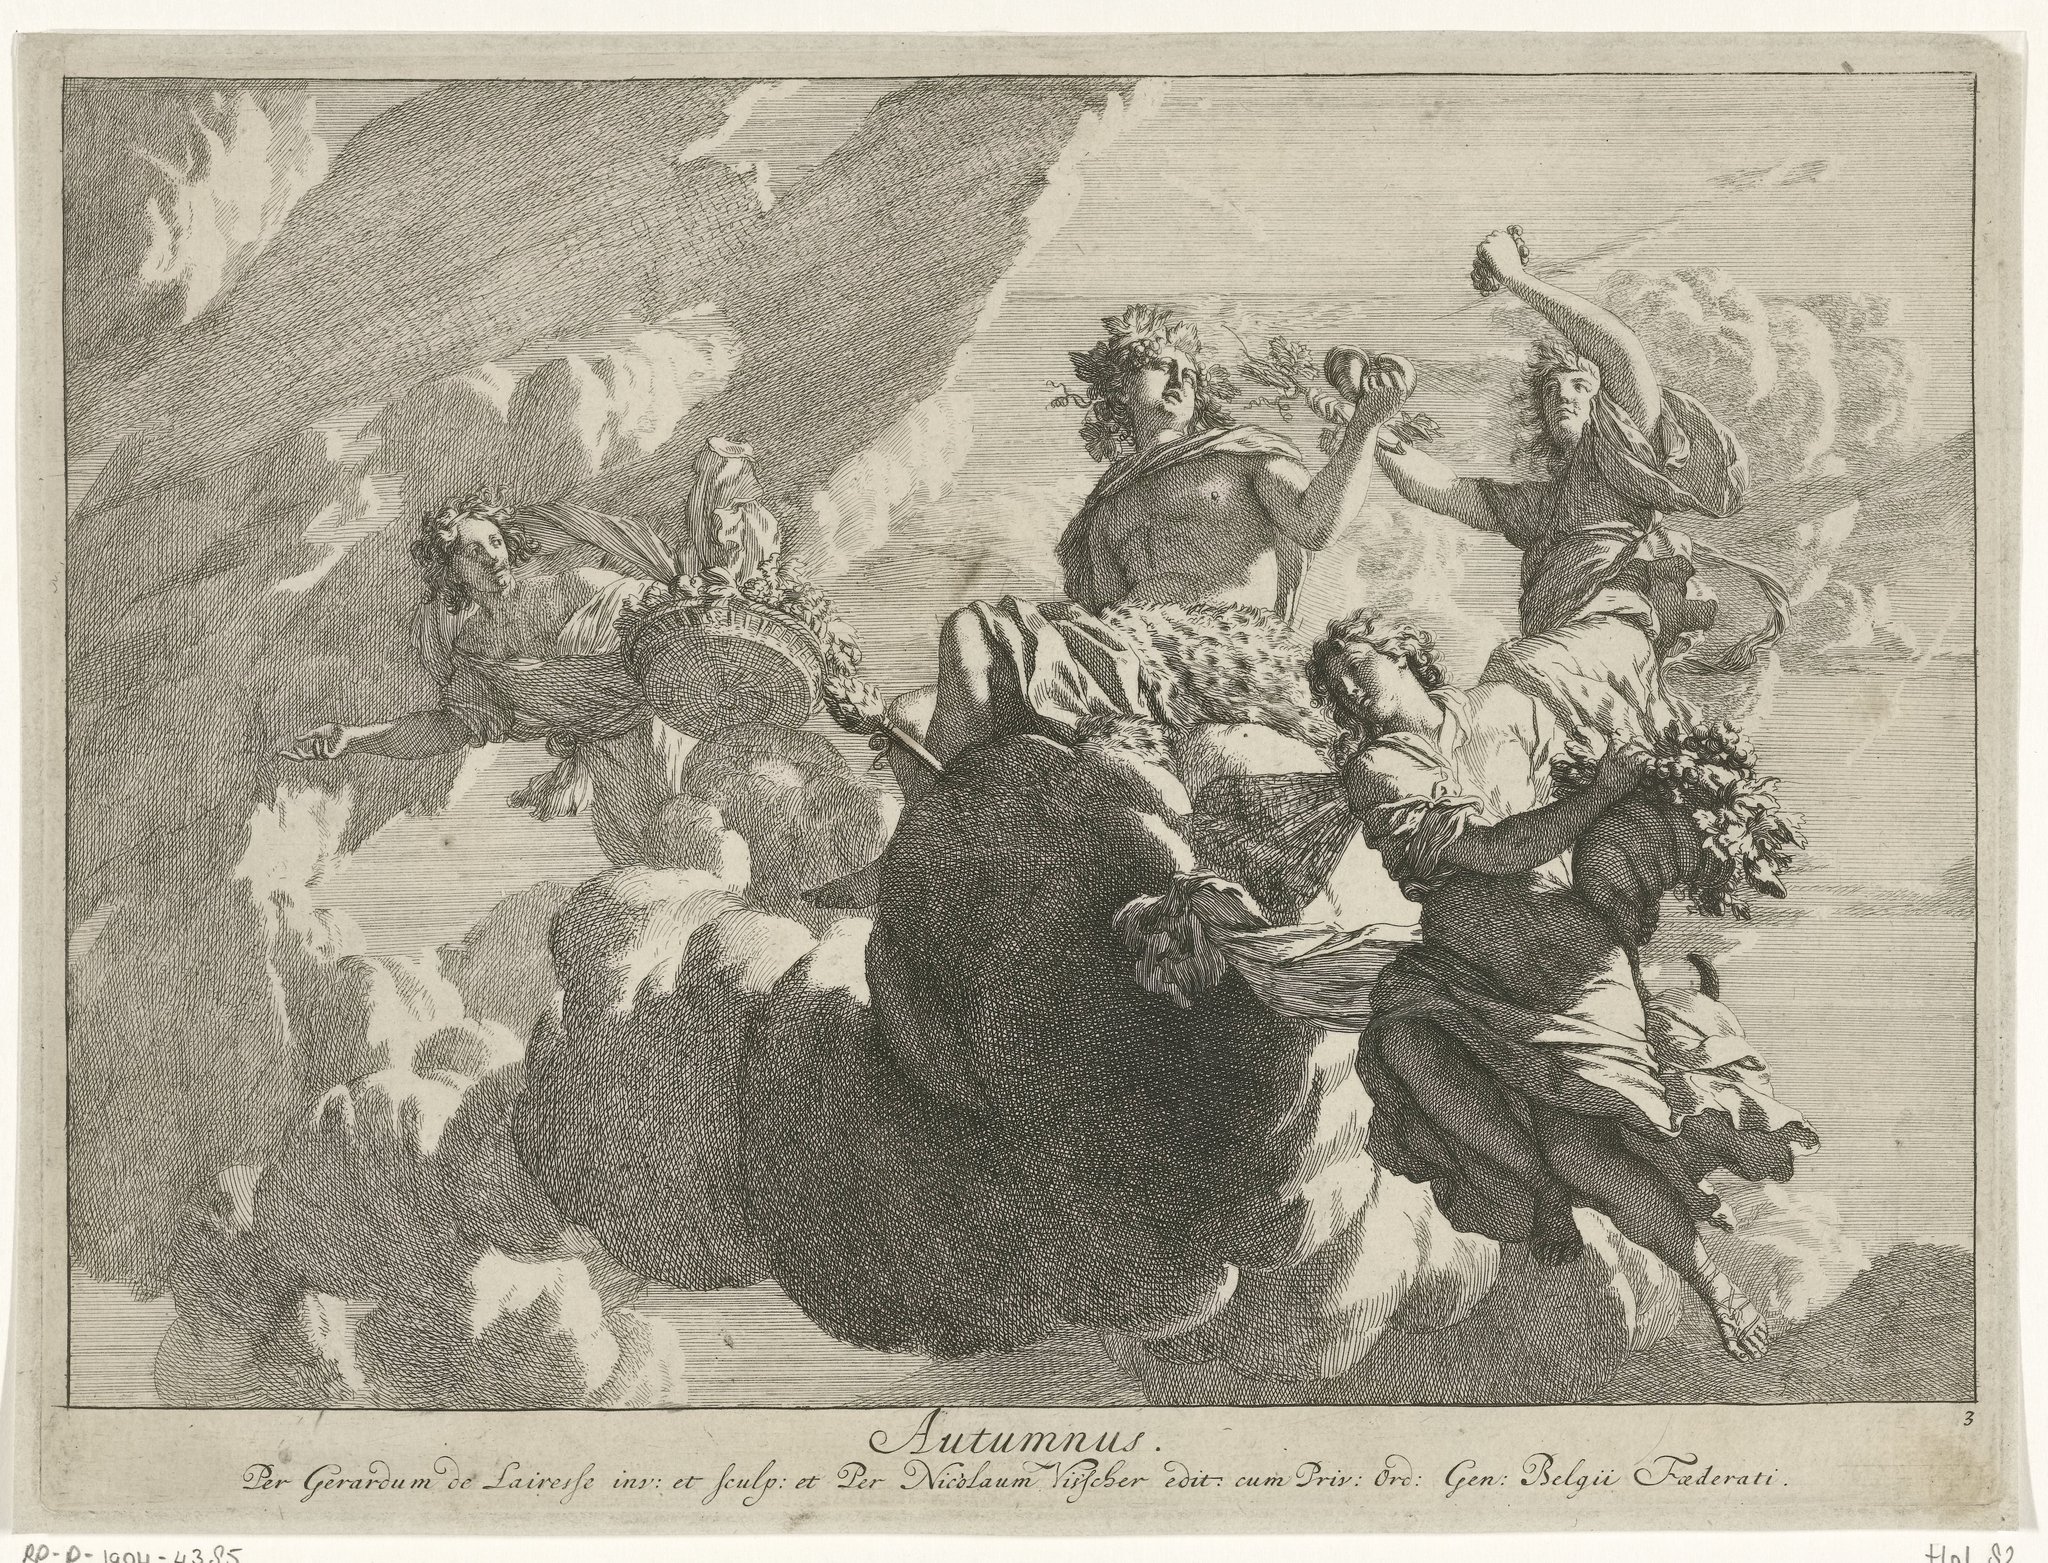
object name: print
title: De vier jaargetijden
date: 1675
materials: paper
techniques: etching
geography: amsterdam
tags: (story of) bacchus (dionysus), liber, autumn, fall, 'autumnus'; 'autunno' (ripa)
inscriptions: collector's mark: Lugt 237a, collector's mark: Lugt 2228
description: Bacchus zit als personificatie van de herfst op een wolk en is omgeven door drie gepersonifieerde maanden die wijnranken en ander seizoensfruit bij zich dragen. Bacchus is gedeeltelijk bedekt met een tijgervel en gekroond met wingerdbladen en druiven, in zijn linkerhand houdt hij een hoorn des overvloeds. De prent maakt deel uit van een vierdelige serie prenten over de vier jaargetijden.